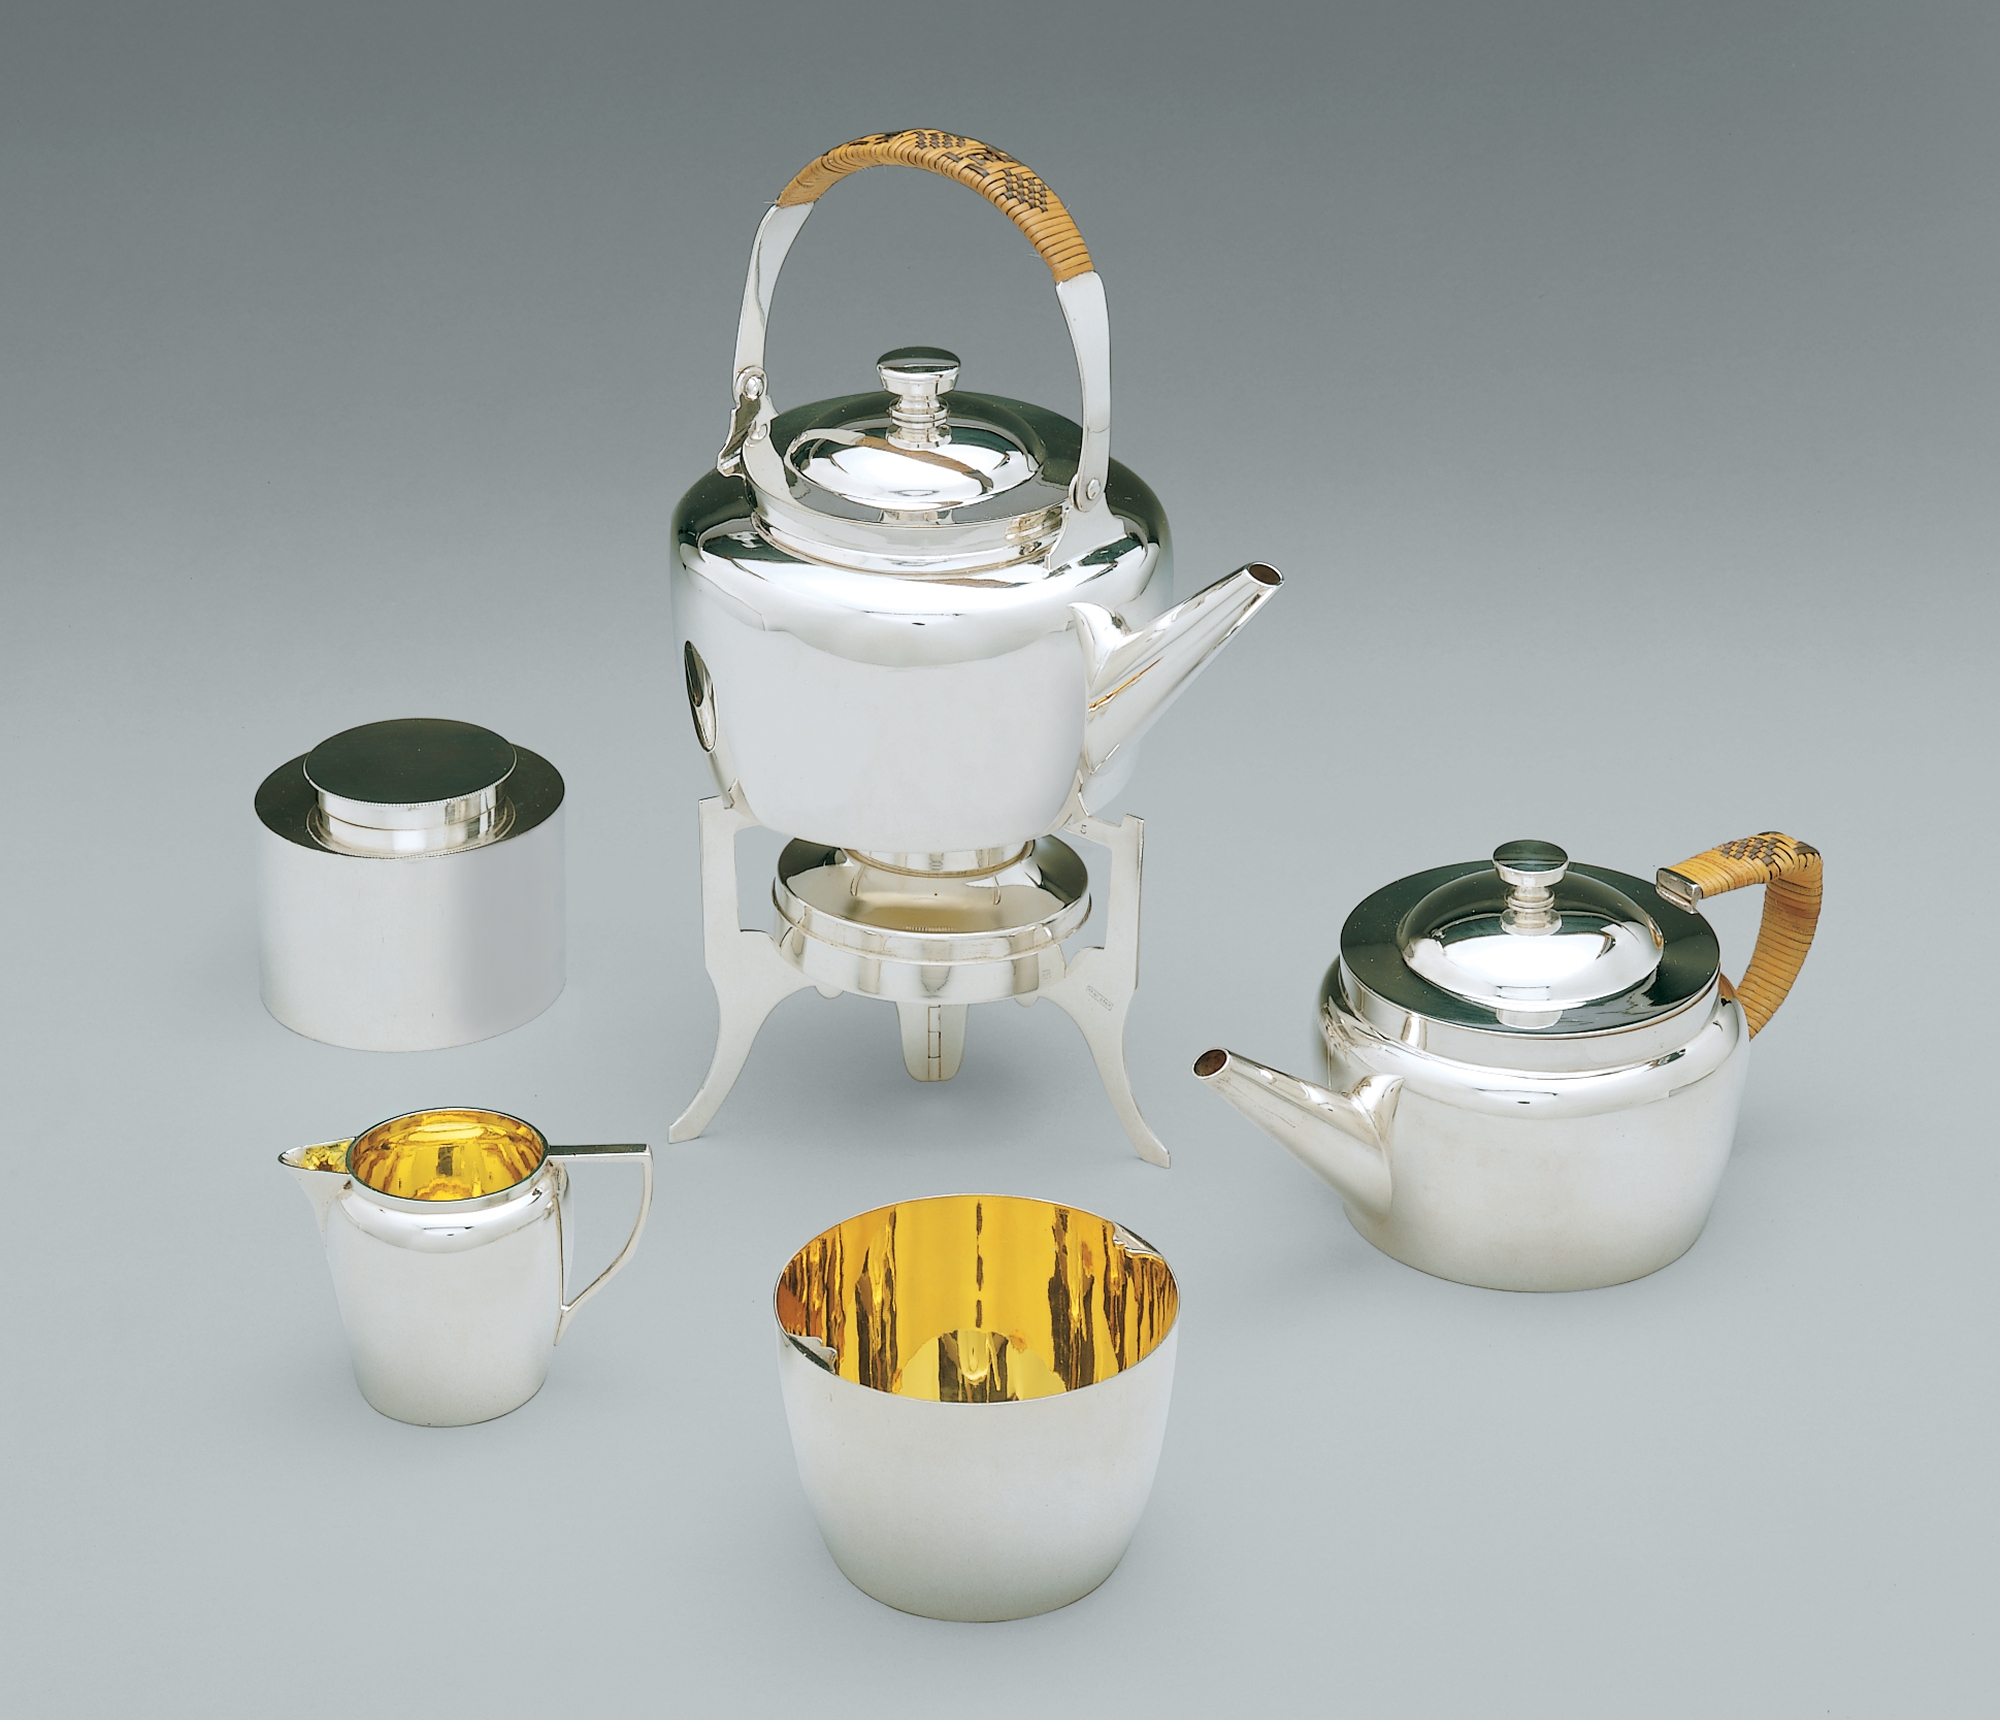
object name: traveling tea set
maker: christopher dresser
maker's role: designer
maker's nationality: british, scottish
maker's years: 1834-1904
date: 1879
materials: bamboo, brass, cotton, gilt, leather, silver, velvet, wood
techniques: glazing